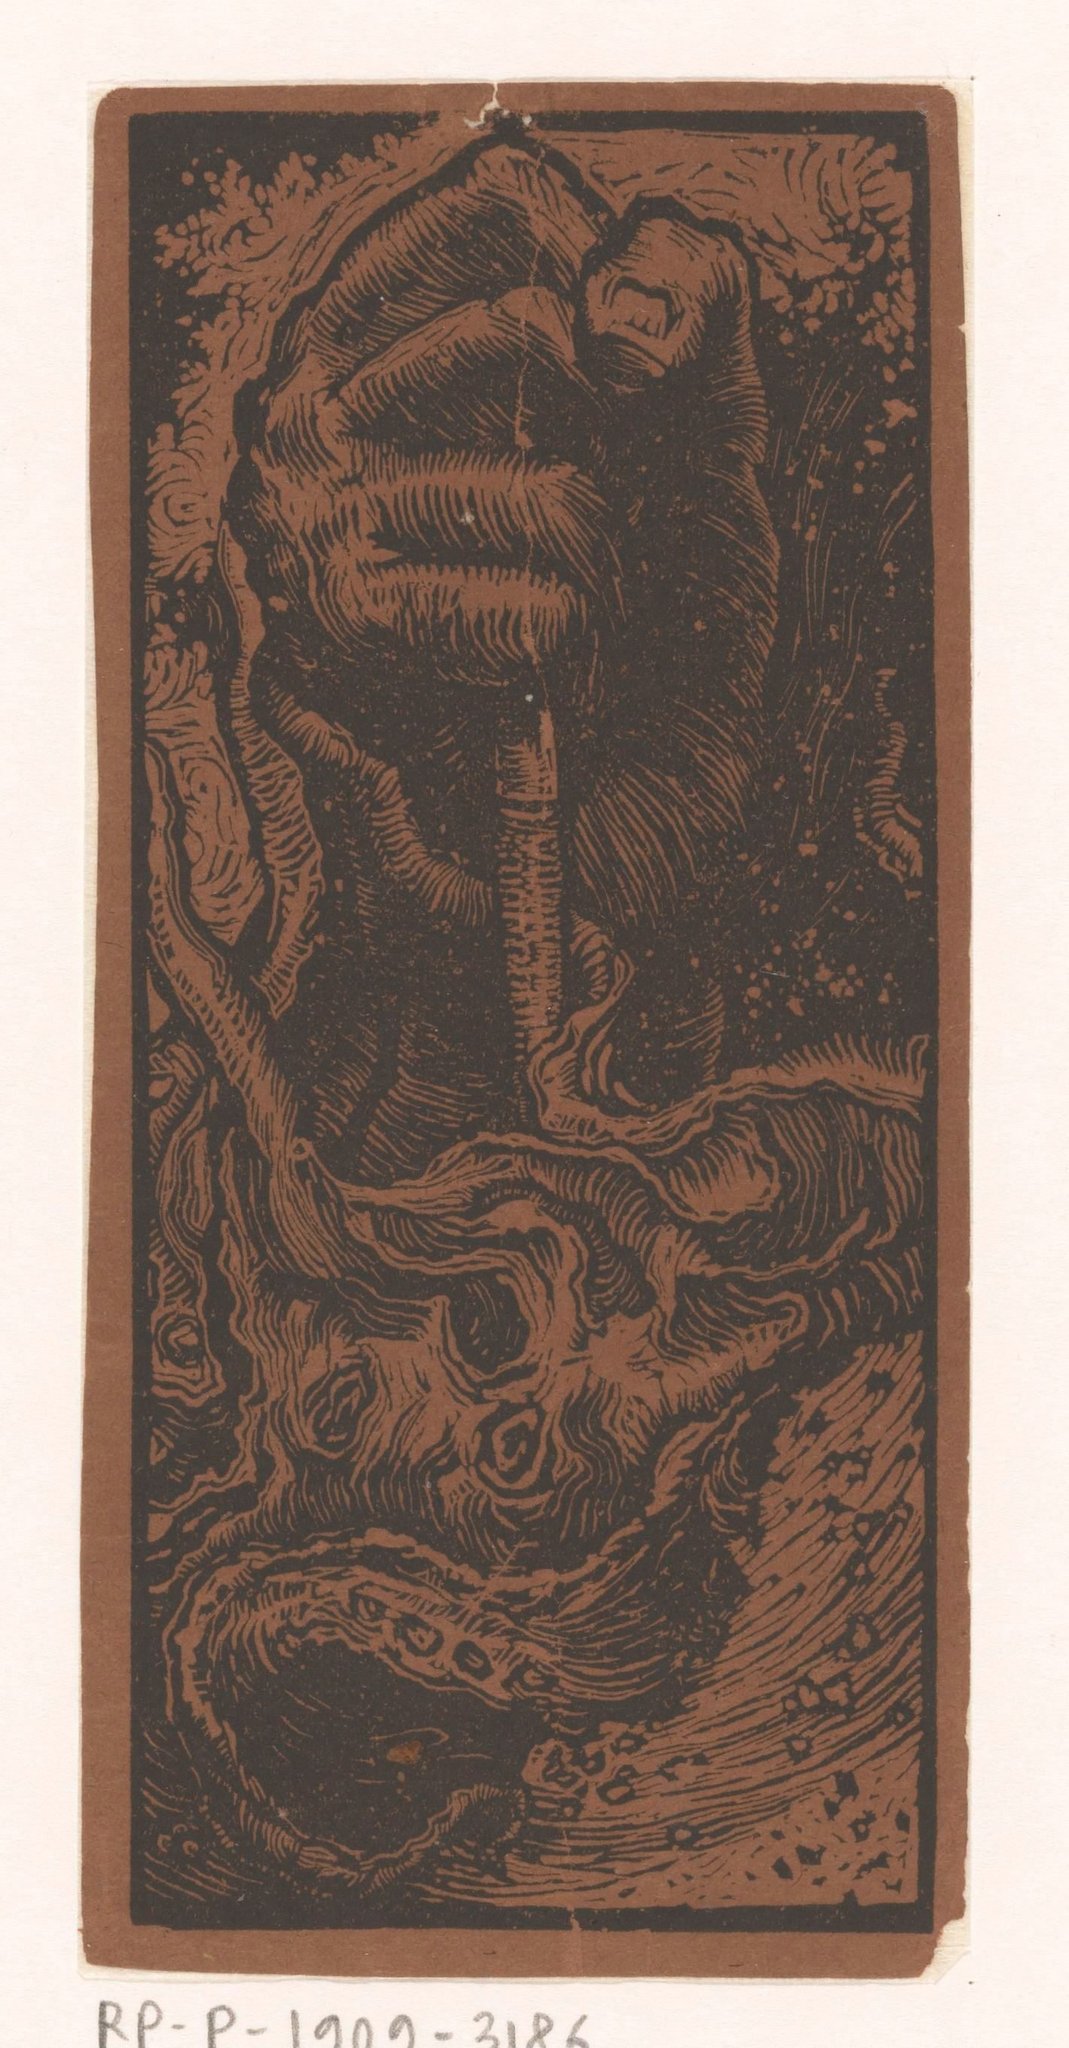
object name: vignette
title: Titelvignet met gebalde vuist voor De Paradox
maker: johannes josephus aarts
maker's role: draughtsman, print maker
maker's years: 1871-1934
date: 1898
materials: paper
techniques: woodcut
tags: vignette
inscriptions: collector's mark: Lugt 2228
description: Titelvignet voor het tijdschrift De Paradox van Alexander Cohen.